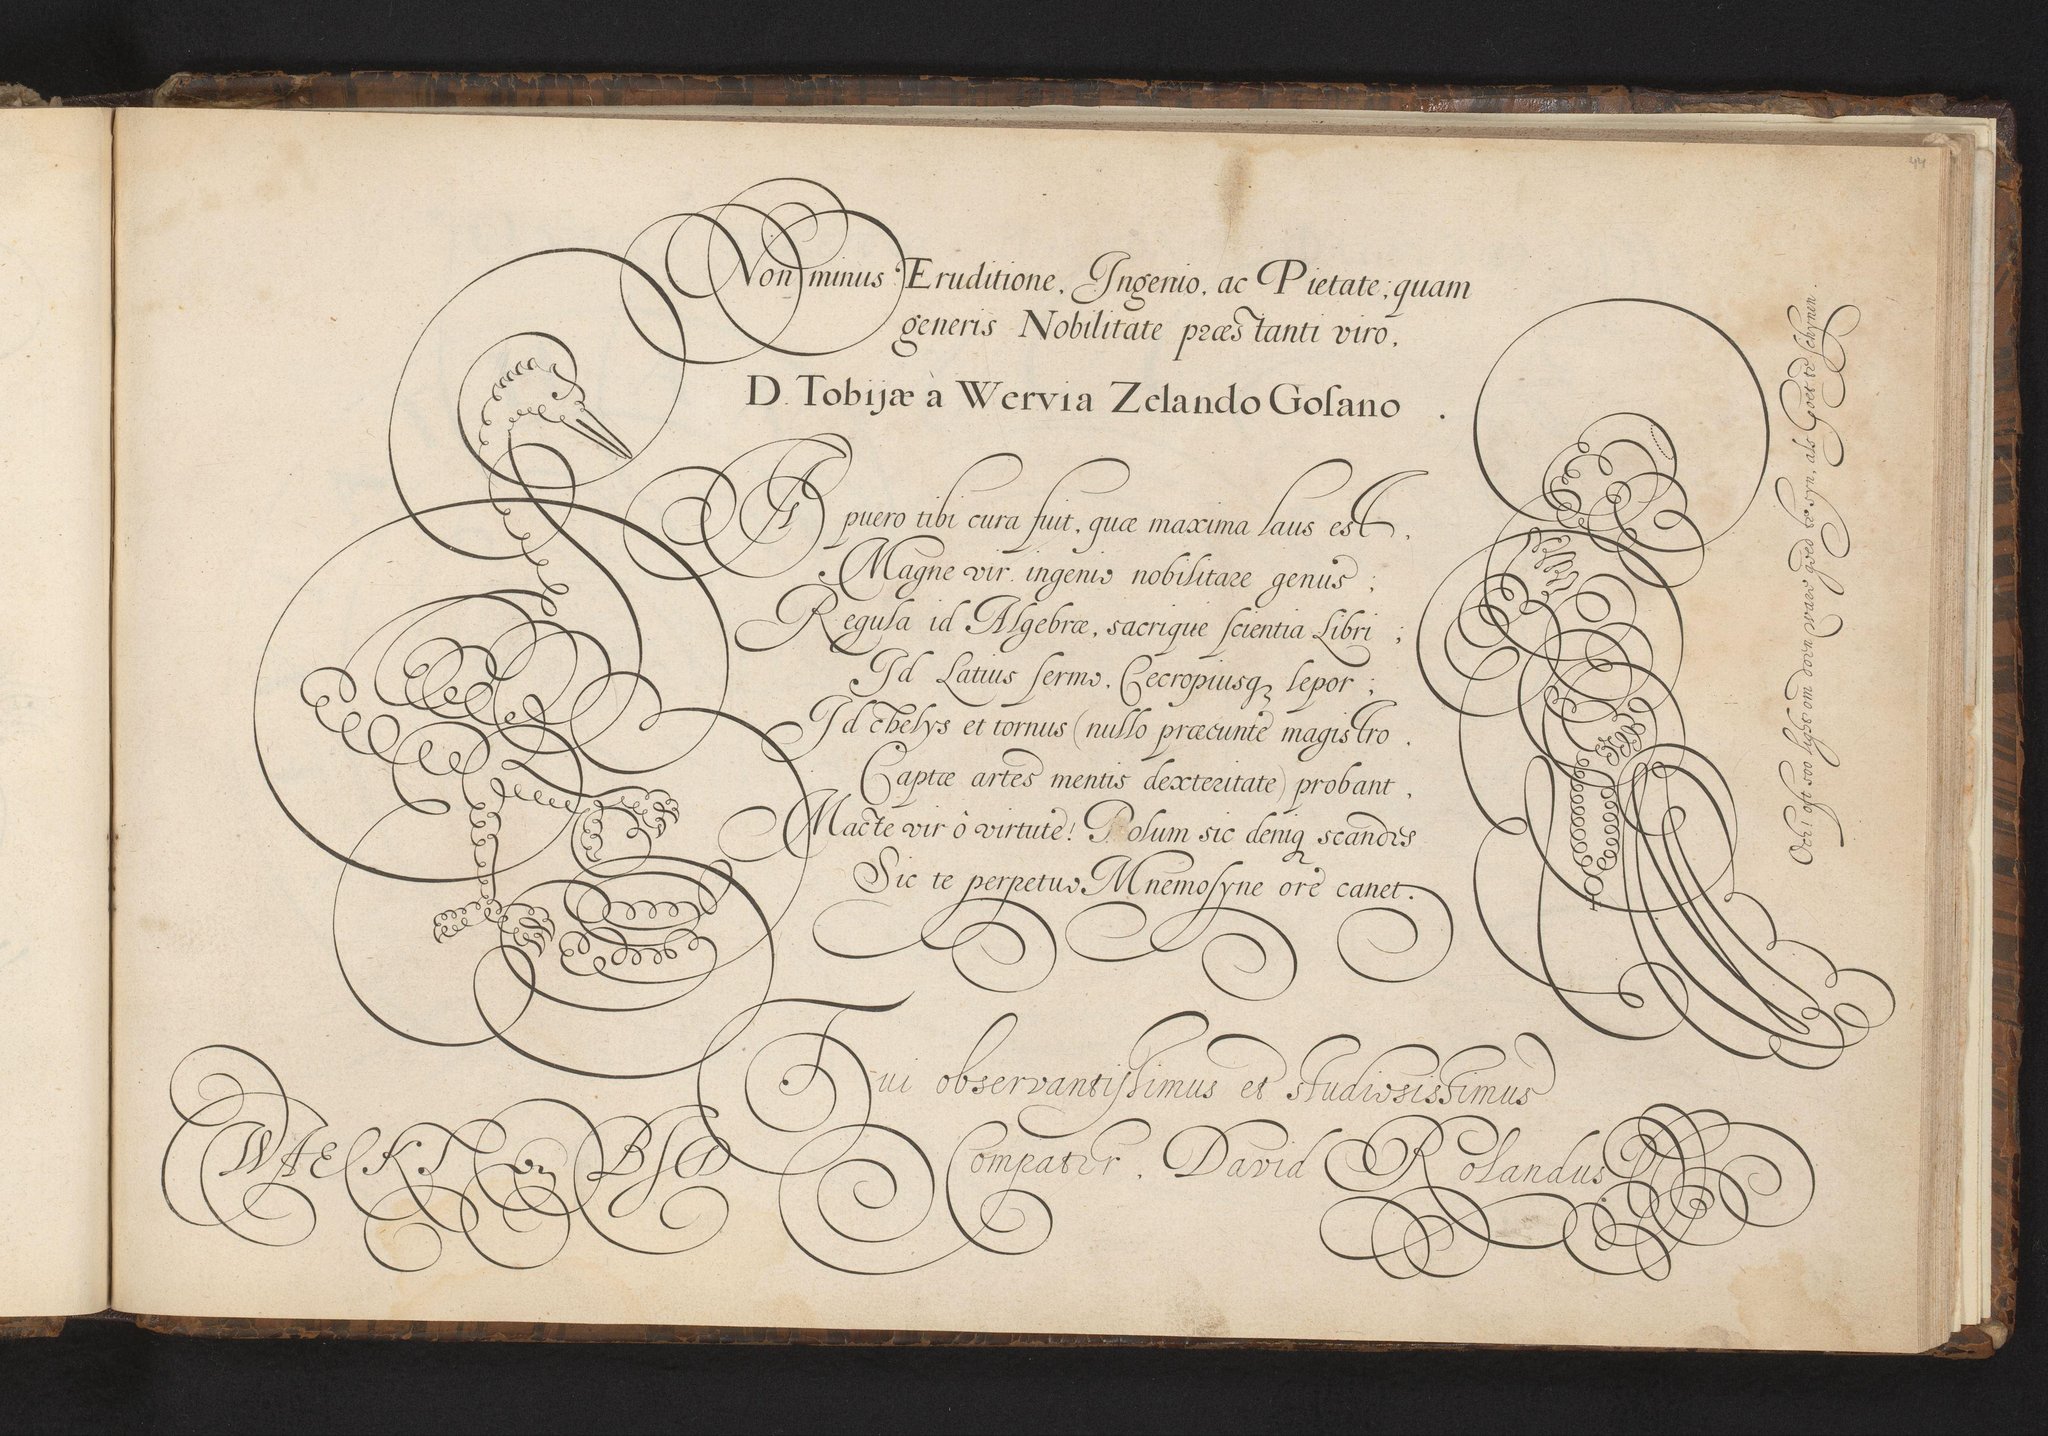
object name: ornament print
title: Schrijfvoorbeeld: Il puero tibi cura fuit (...)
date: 1616-1617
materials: paper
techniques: engraving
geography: flushing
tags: calligraphy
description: Schrijfvoorbeeld met acht regels tekst in het Latijn: Il puero tibi cura fuit ... Daarboven drie regels tekst met een opdracht aan Tobias van de Werve uit Goes. De tekst wordt geflankeerd door een vogel en een monnik in krulwerk. De prent maakt deel uit van een album.